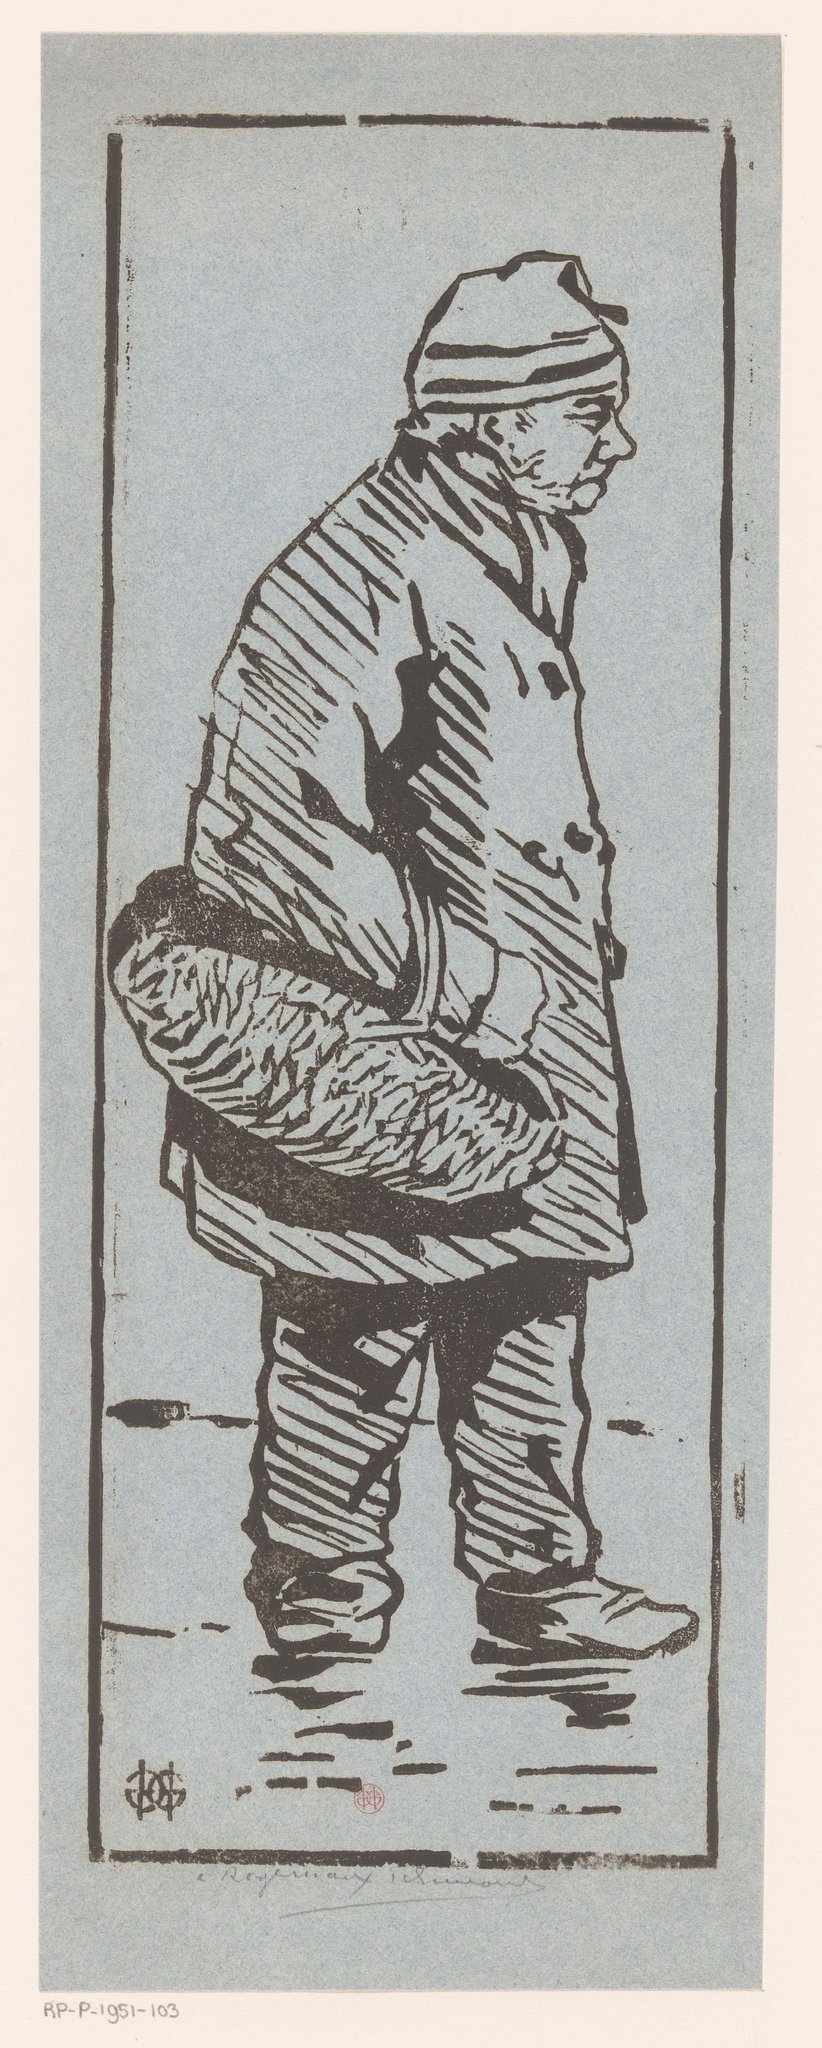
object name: print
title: Oude man met mand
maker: henri charles guérard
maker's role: print maker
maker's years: 1846-1897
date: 1856-1897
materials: paper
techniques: woodcut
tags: carrying something in basket, bag, rucksack, etc., old man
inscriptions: collector's mark: Lugt 2228, stamp: Lugt 1157